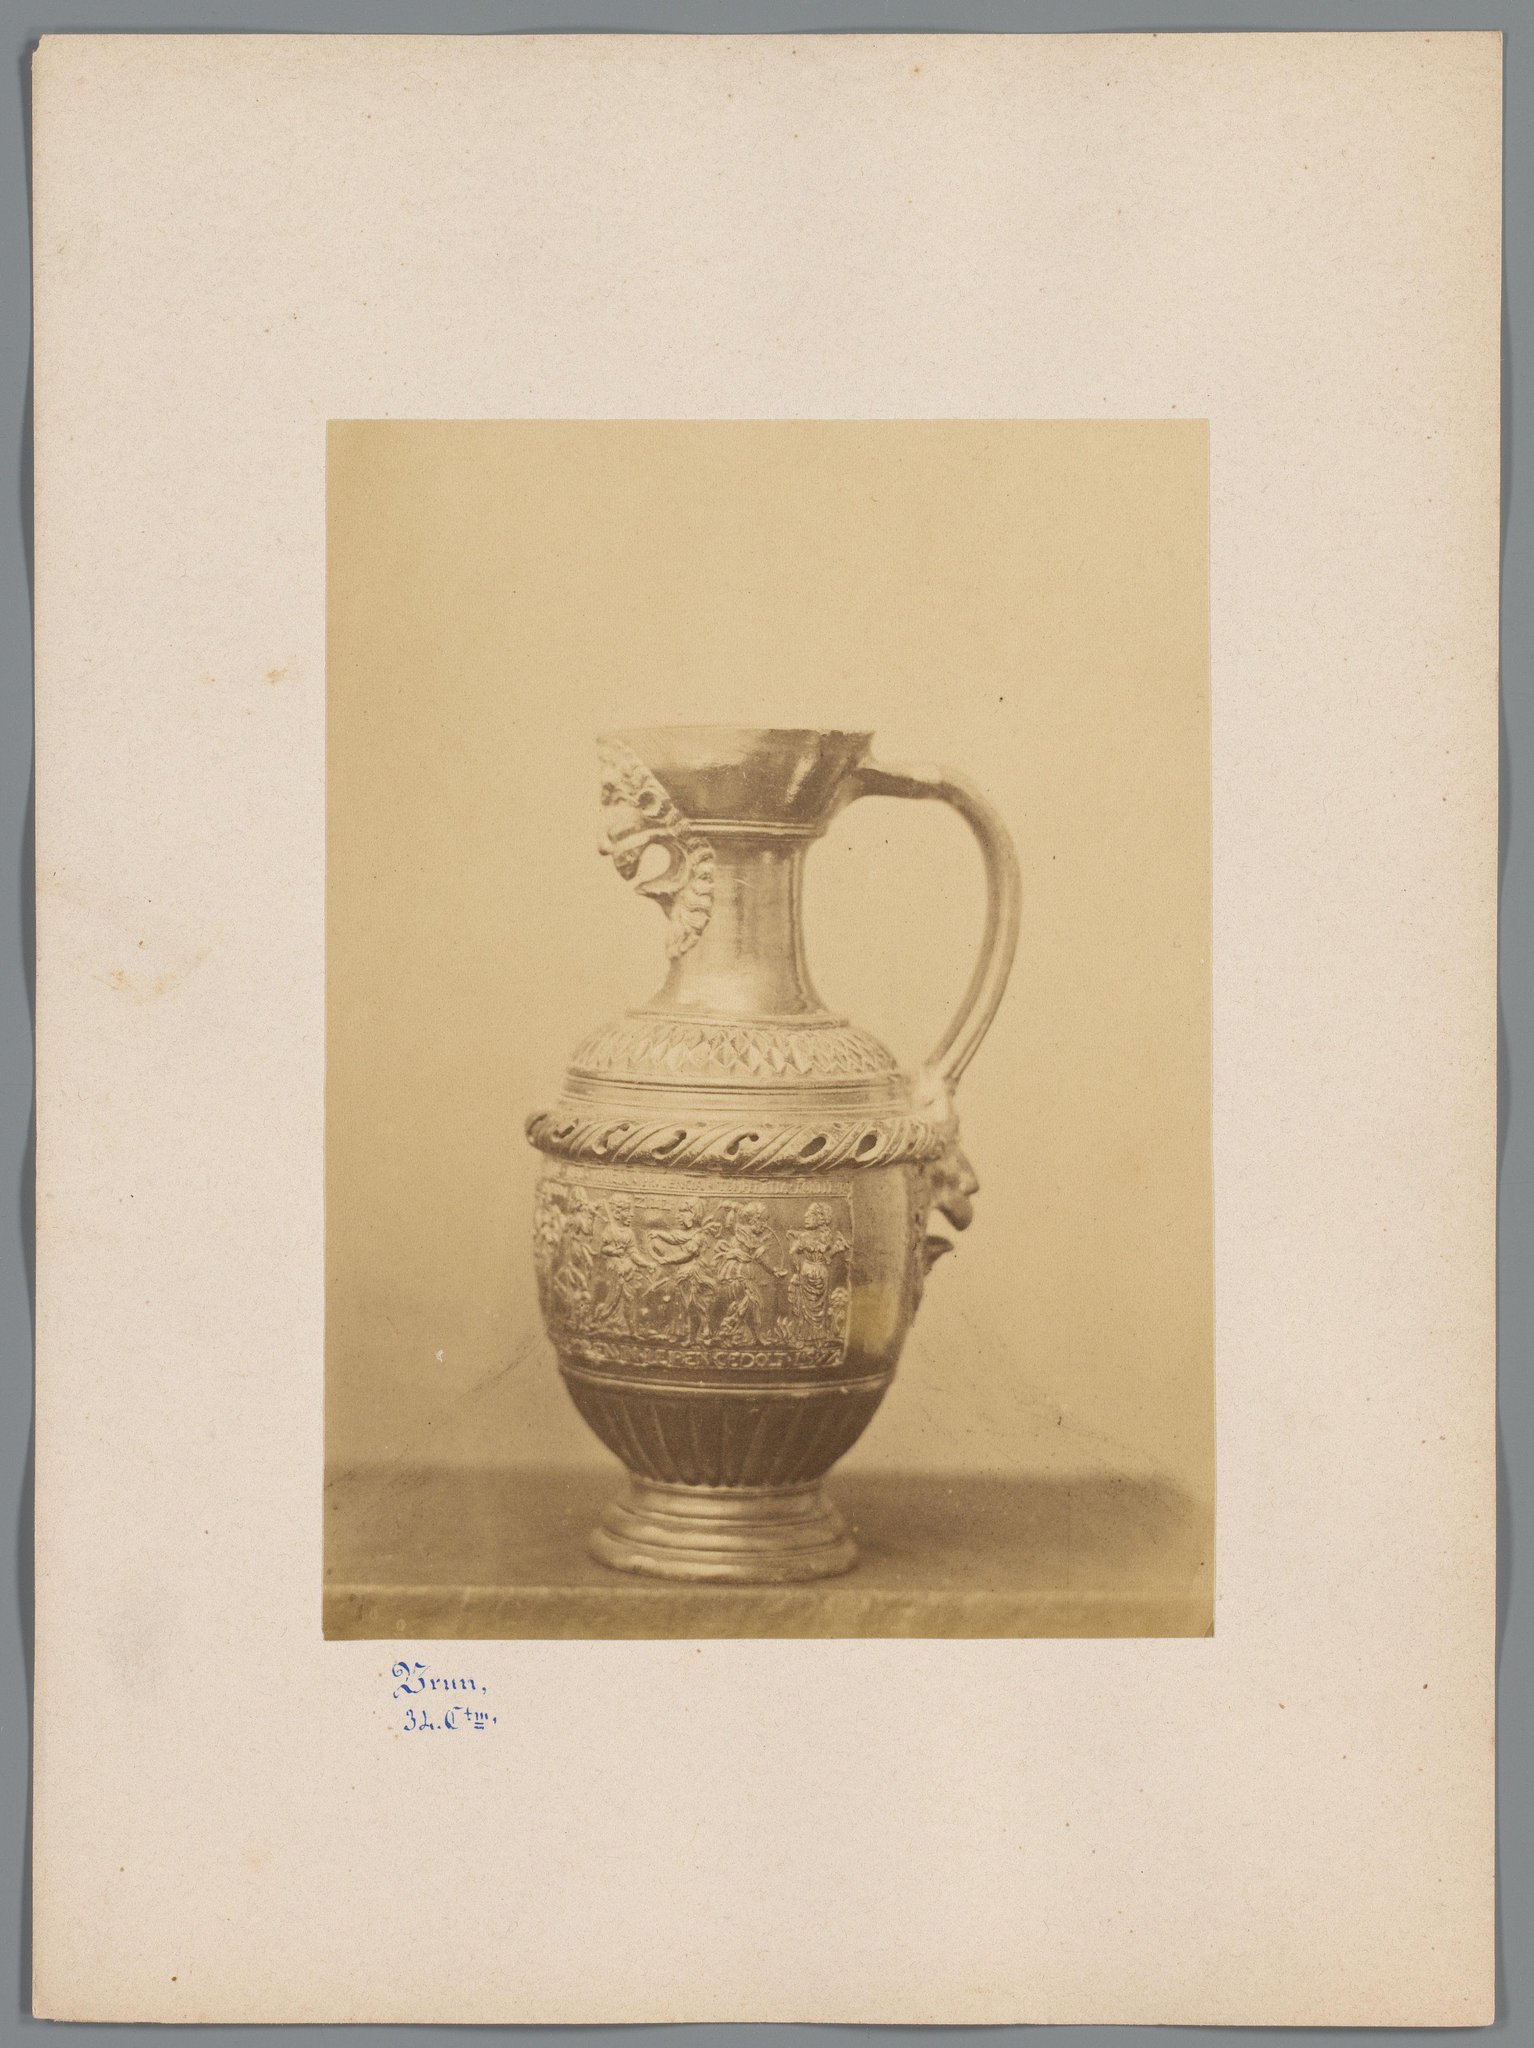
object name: photograph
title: Aardewerken vaas uit de collectie van W. de Weckherlin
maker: Anonymous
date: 1860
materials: paper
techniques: albumen print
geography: the hague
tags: container of ceramics: jar, jug, pot, vase, the hague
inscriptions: inscription: ‘Brun 34Ctm’